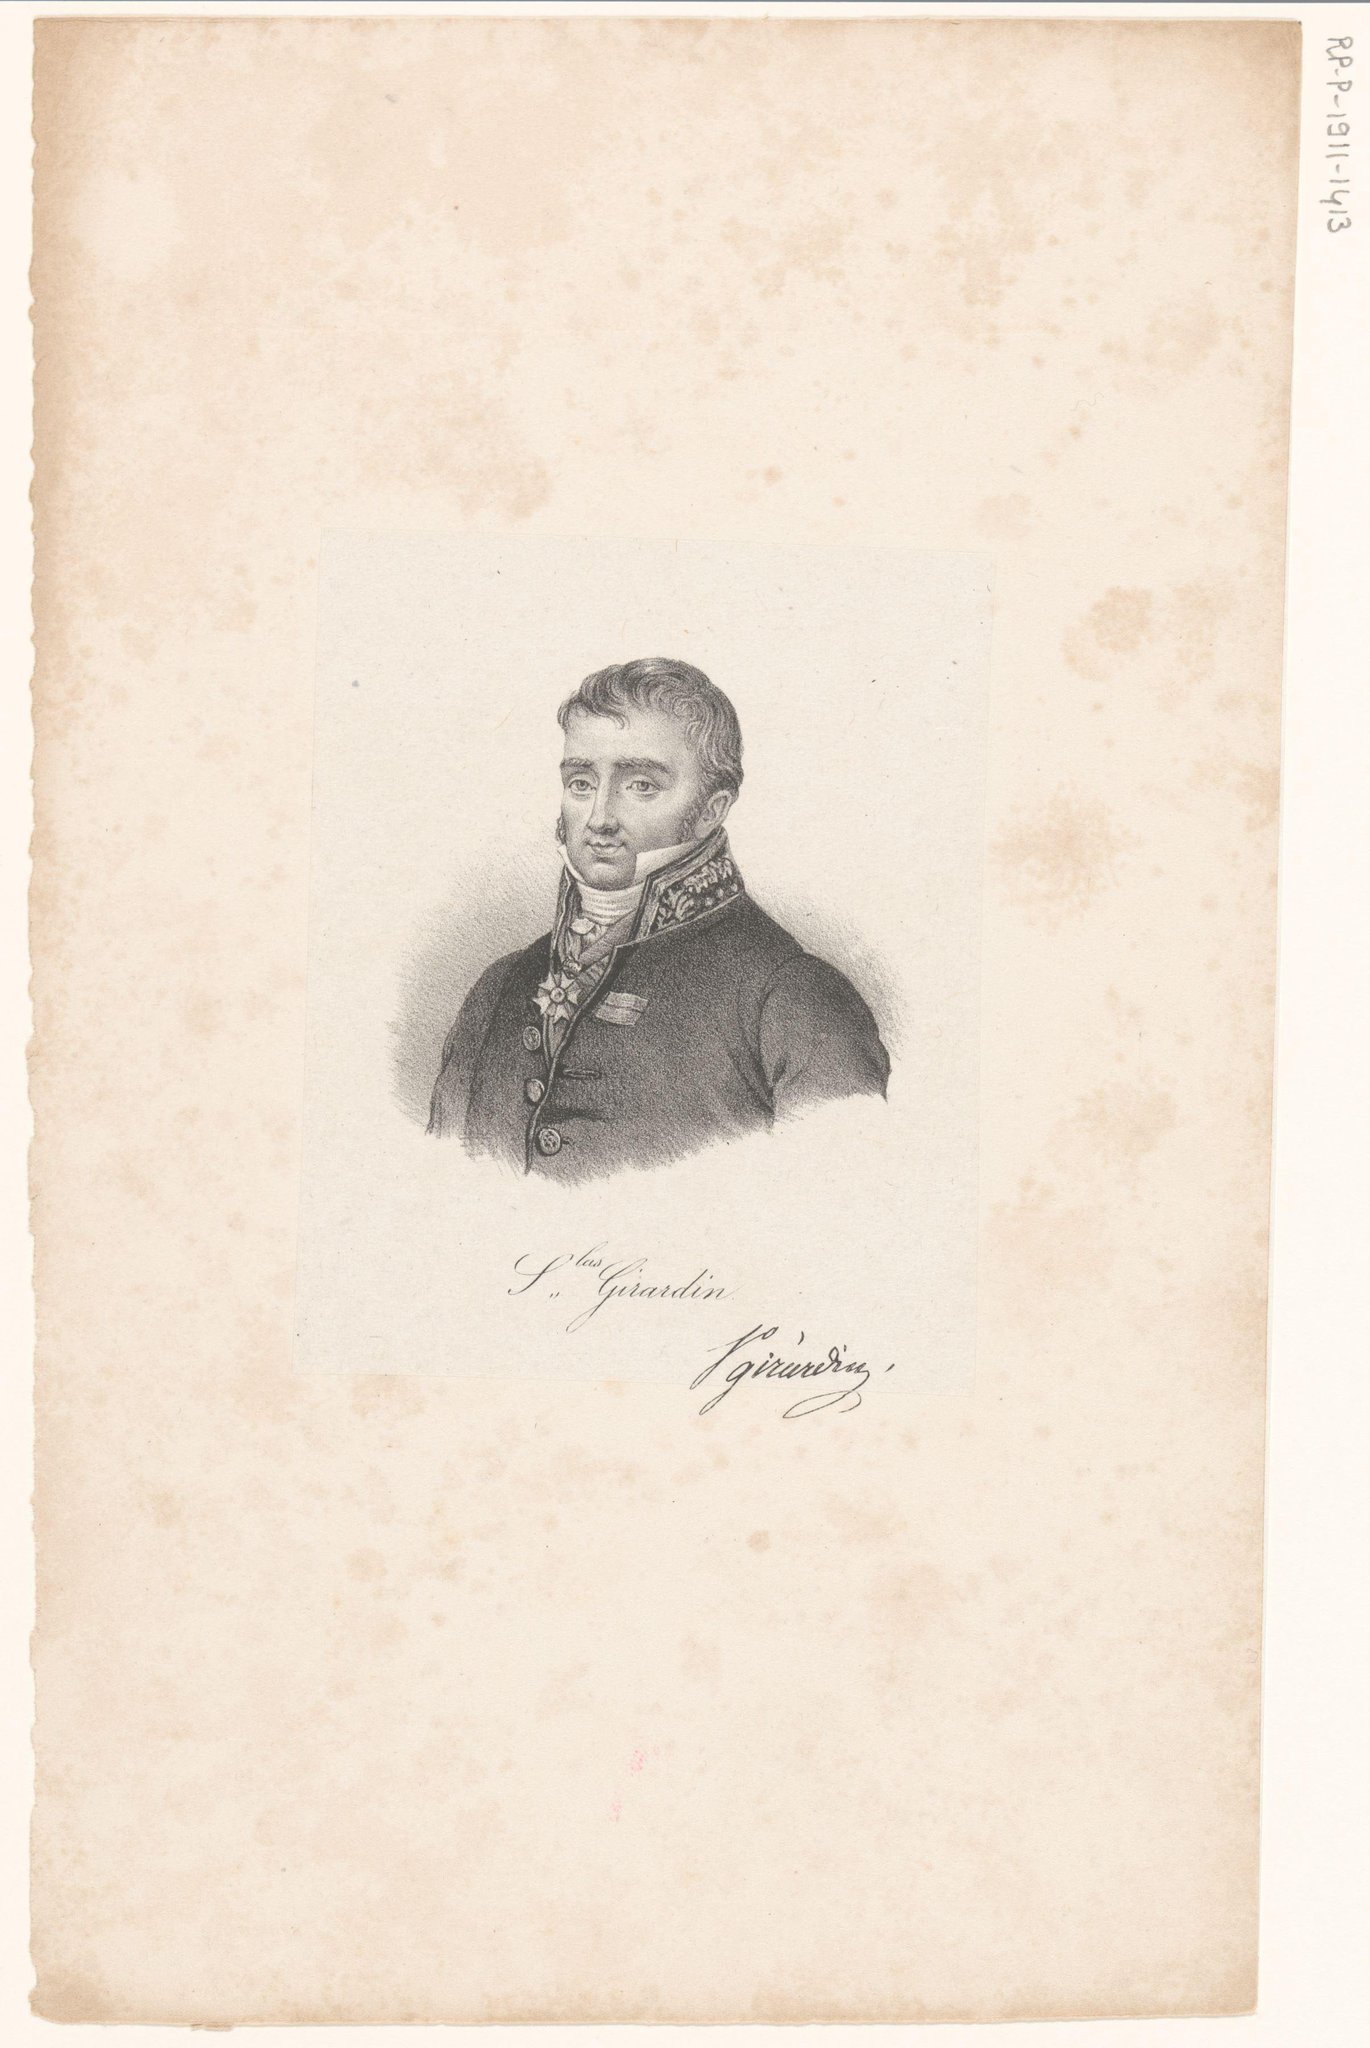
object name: print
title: Portret van Louis Stanislas de Girardin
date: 1818-1842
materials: paper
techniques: lithograph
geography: paris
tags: paris, politician, historical persons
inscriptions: collector's mark: Lugt 2228a